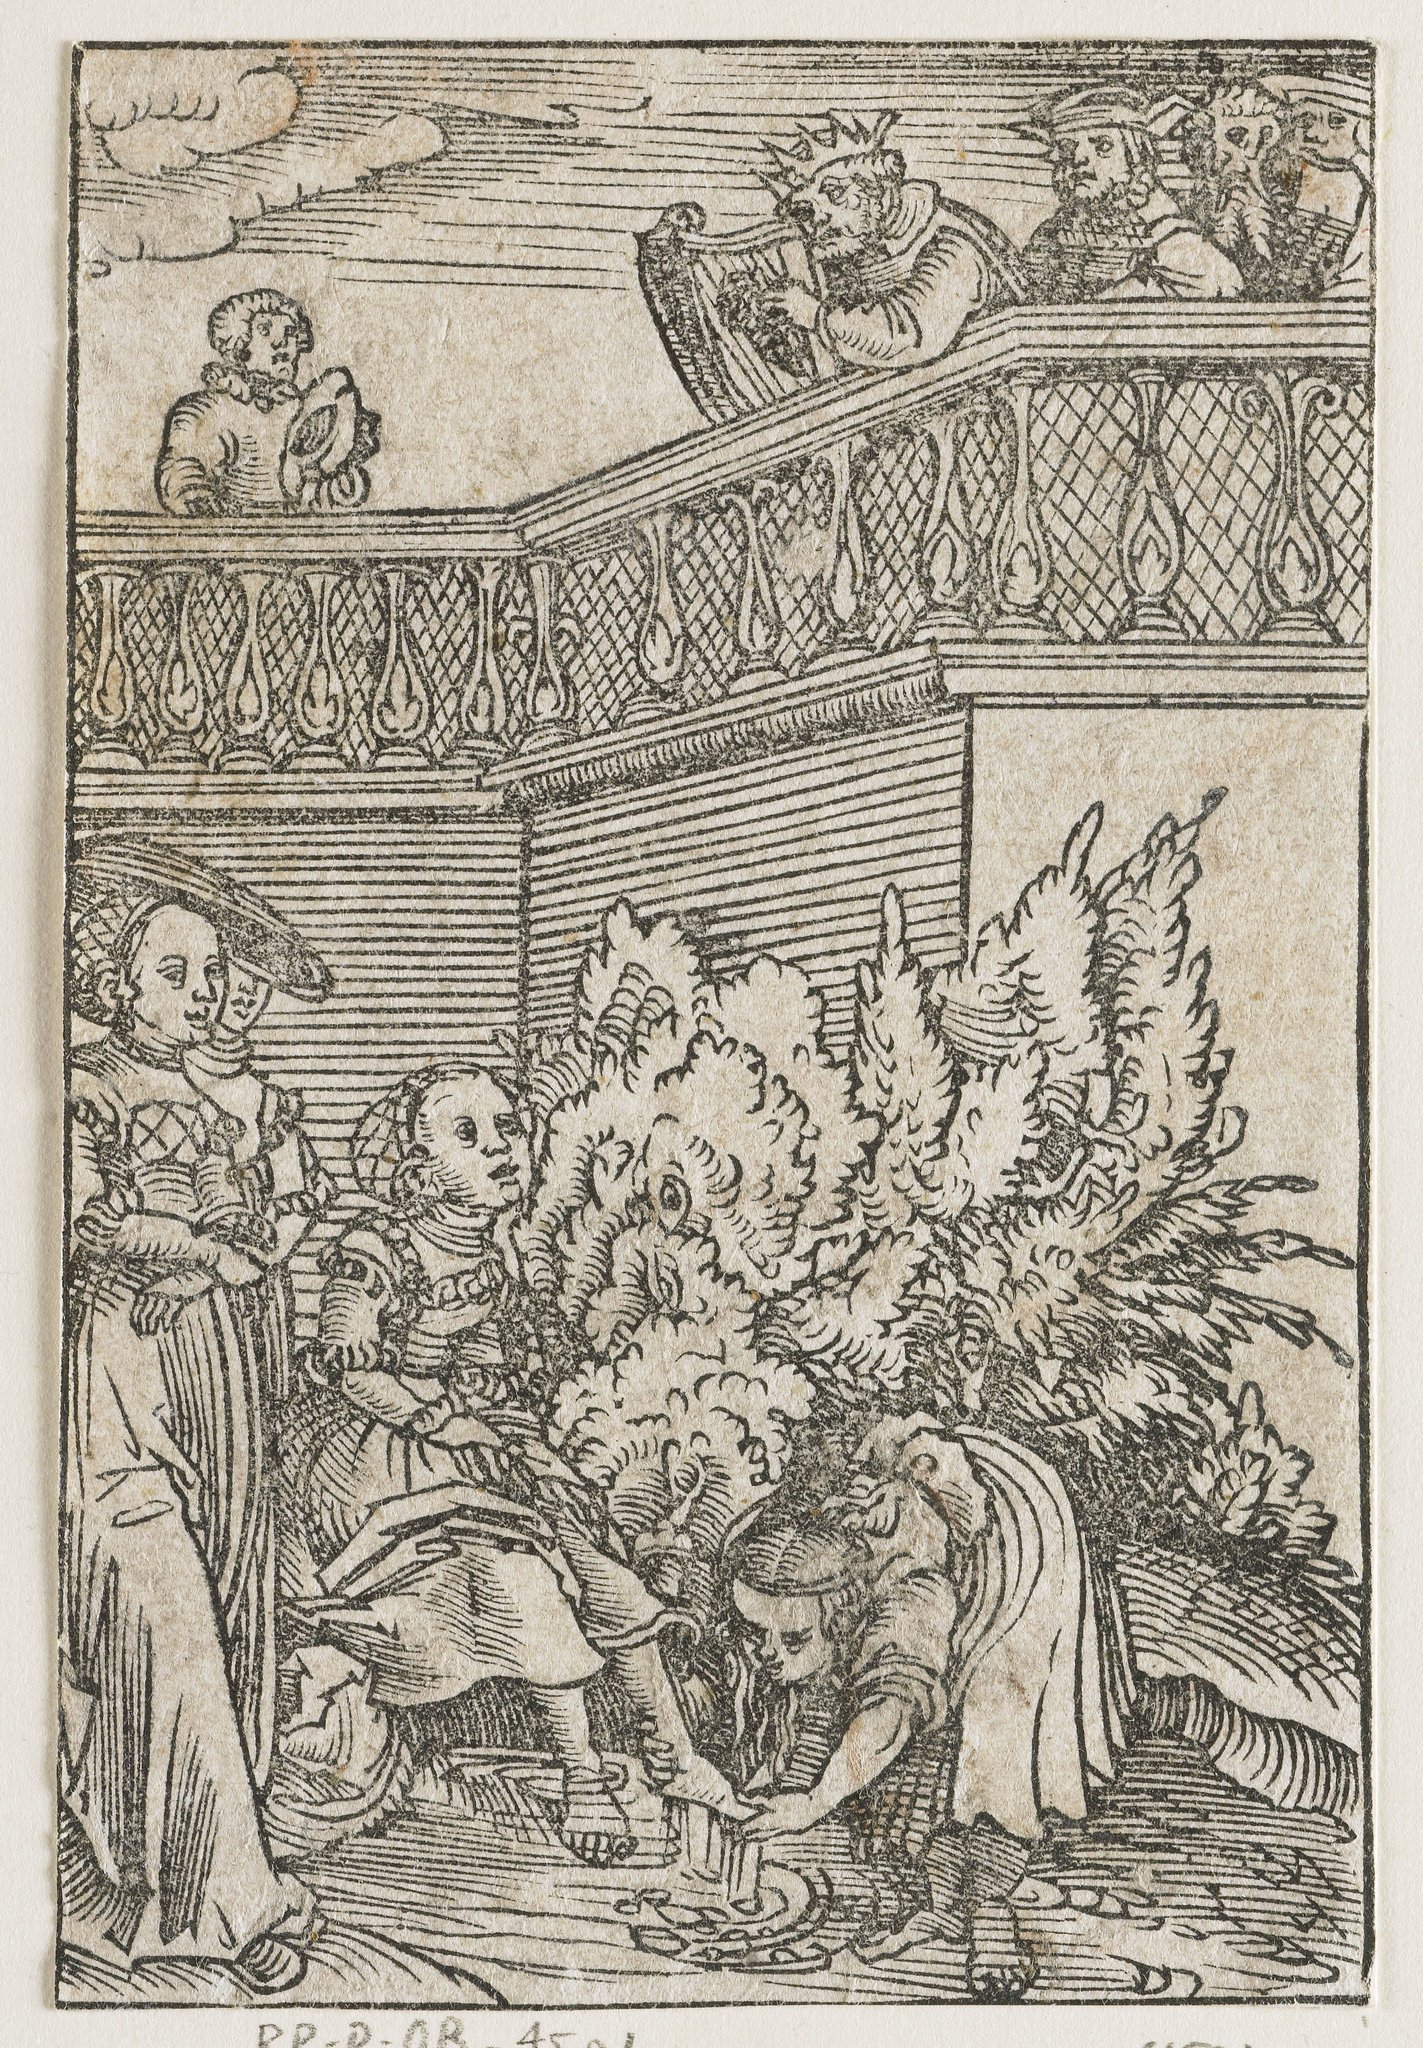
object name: print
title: David ziet Batseba in zijn tuin een bad nemen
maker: lucas cranach (i)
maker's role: draughtsman, print maker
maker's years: 1472-1553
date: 1528-1554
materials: paper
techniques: woodcut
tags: david, from the roof (or balcony) of his palace, sees bathsheba bathing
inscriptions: collector's mark: Lugt 240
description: Batseba neemt in de tuin van het paleis van koning David een bad, geholpen door twee dienaressen. Op het dak van het paleis staat de koning met zijn harp, hij ziet Batseba baden in zijn tuin. Dit verhaal verwijst naar het zesde gebod Gij zult geen overspel plegen. Zesde prent in een serie van tien prenten.